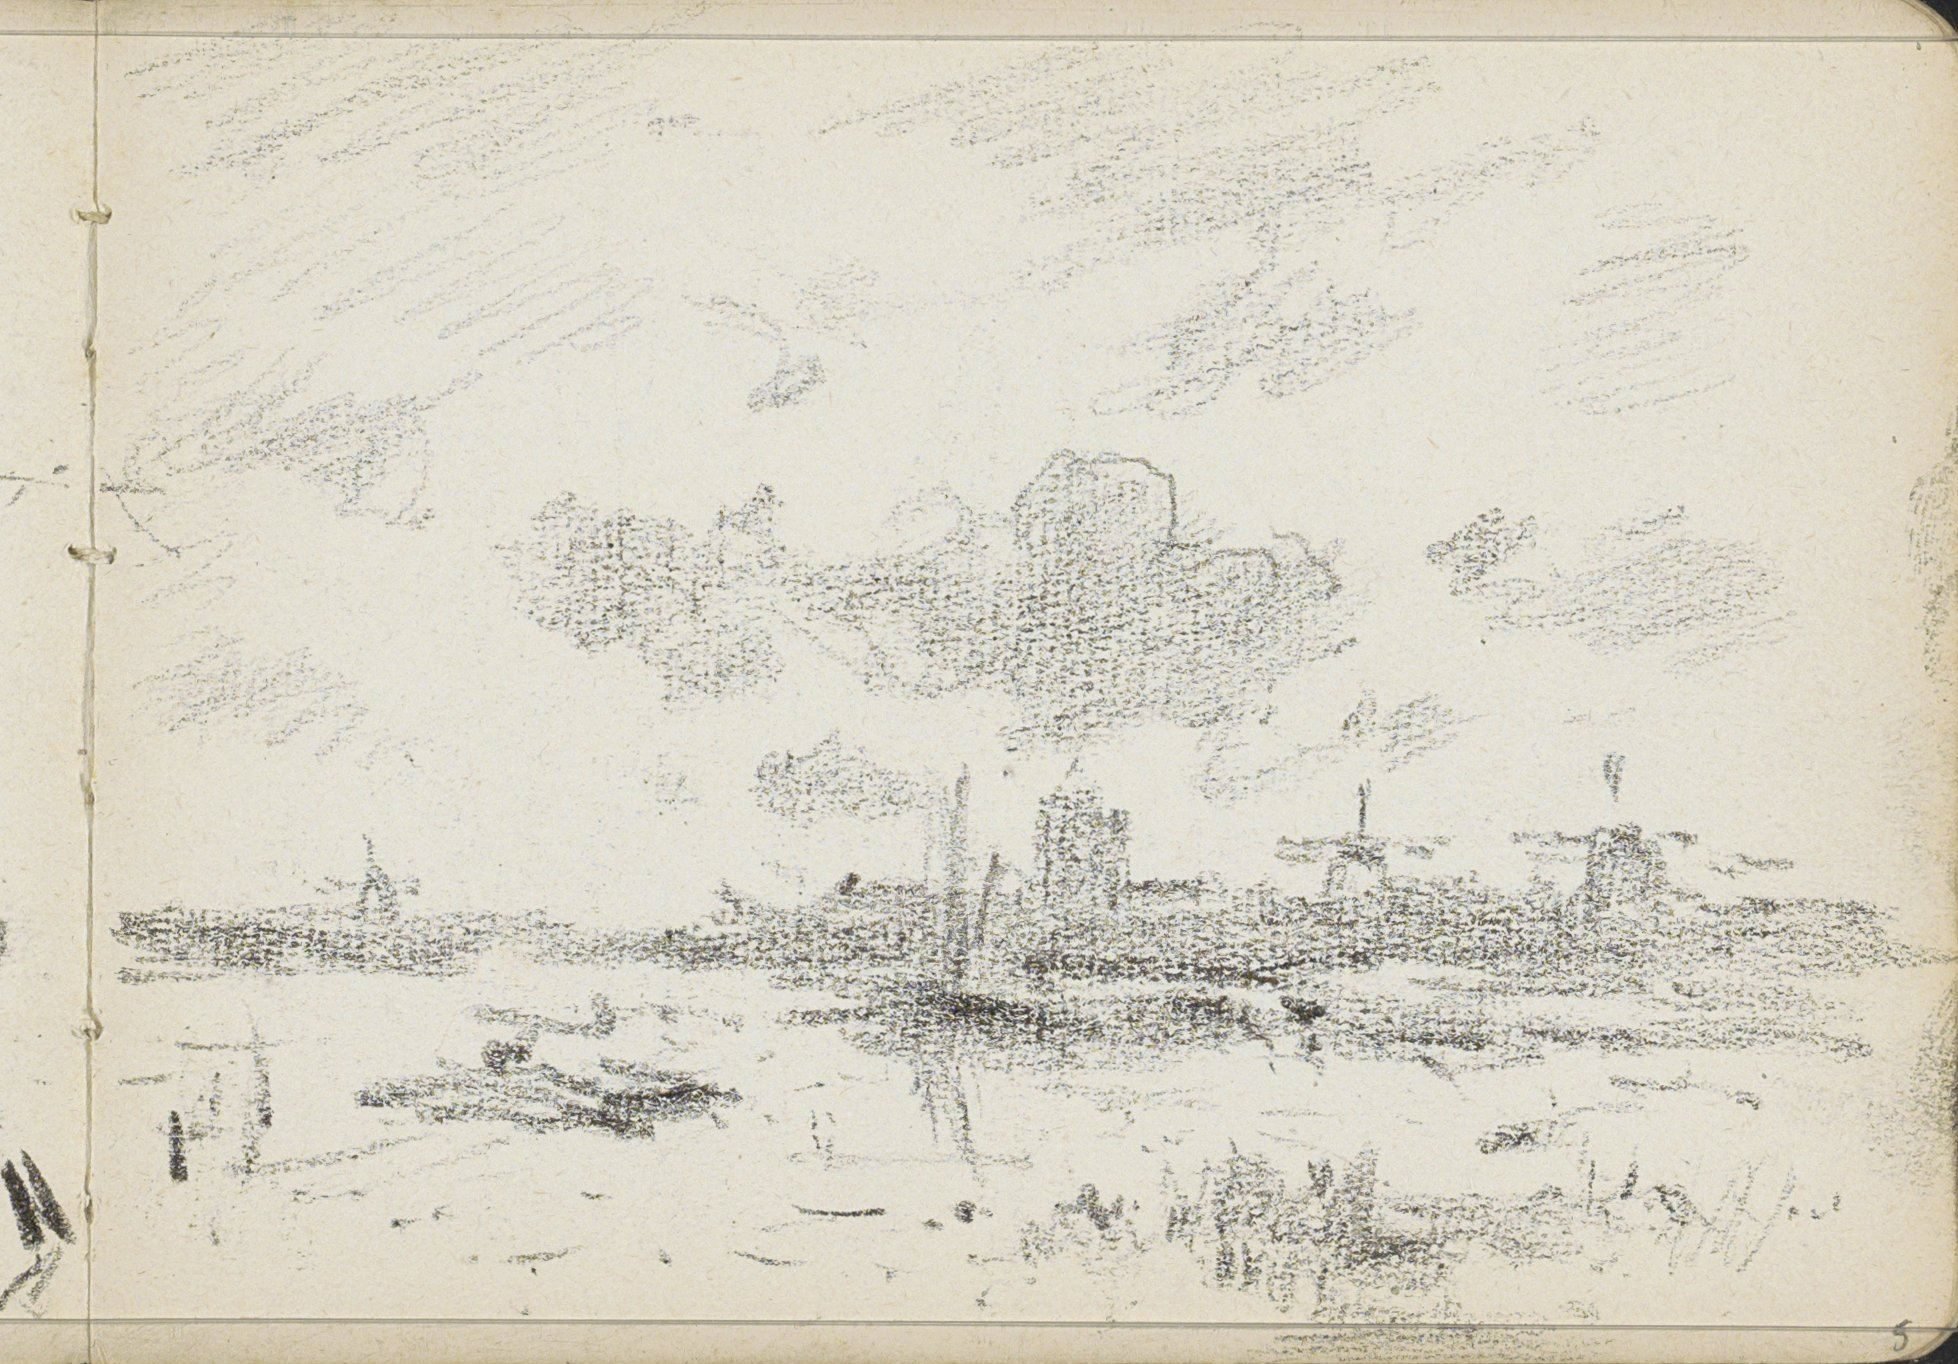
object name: sketchbook leaf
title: Rivierlandschap met molens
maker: willem cornelis rip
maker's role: draughtsman, painter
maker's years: 1856-1922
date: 1866-1922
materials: chalk, paper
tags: landscapes with waters, waterscapes, seascapes (in the temperate zone), windmill in landscape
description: Blad 5 recto uit een schetsboek met 42 bladen.